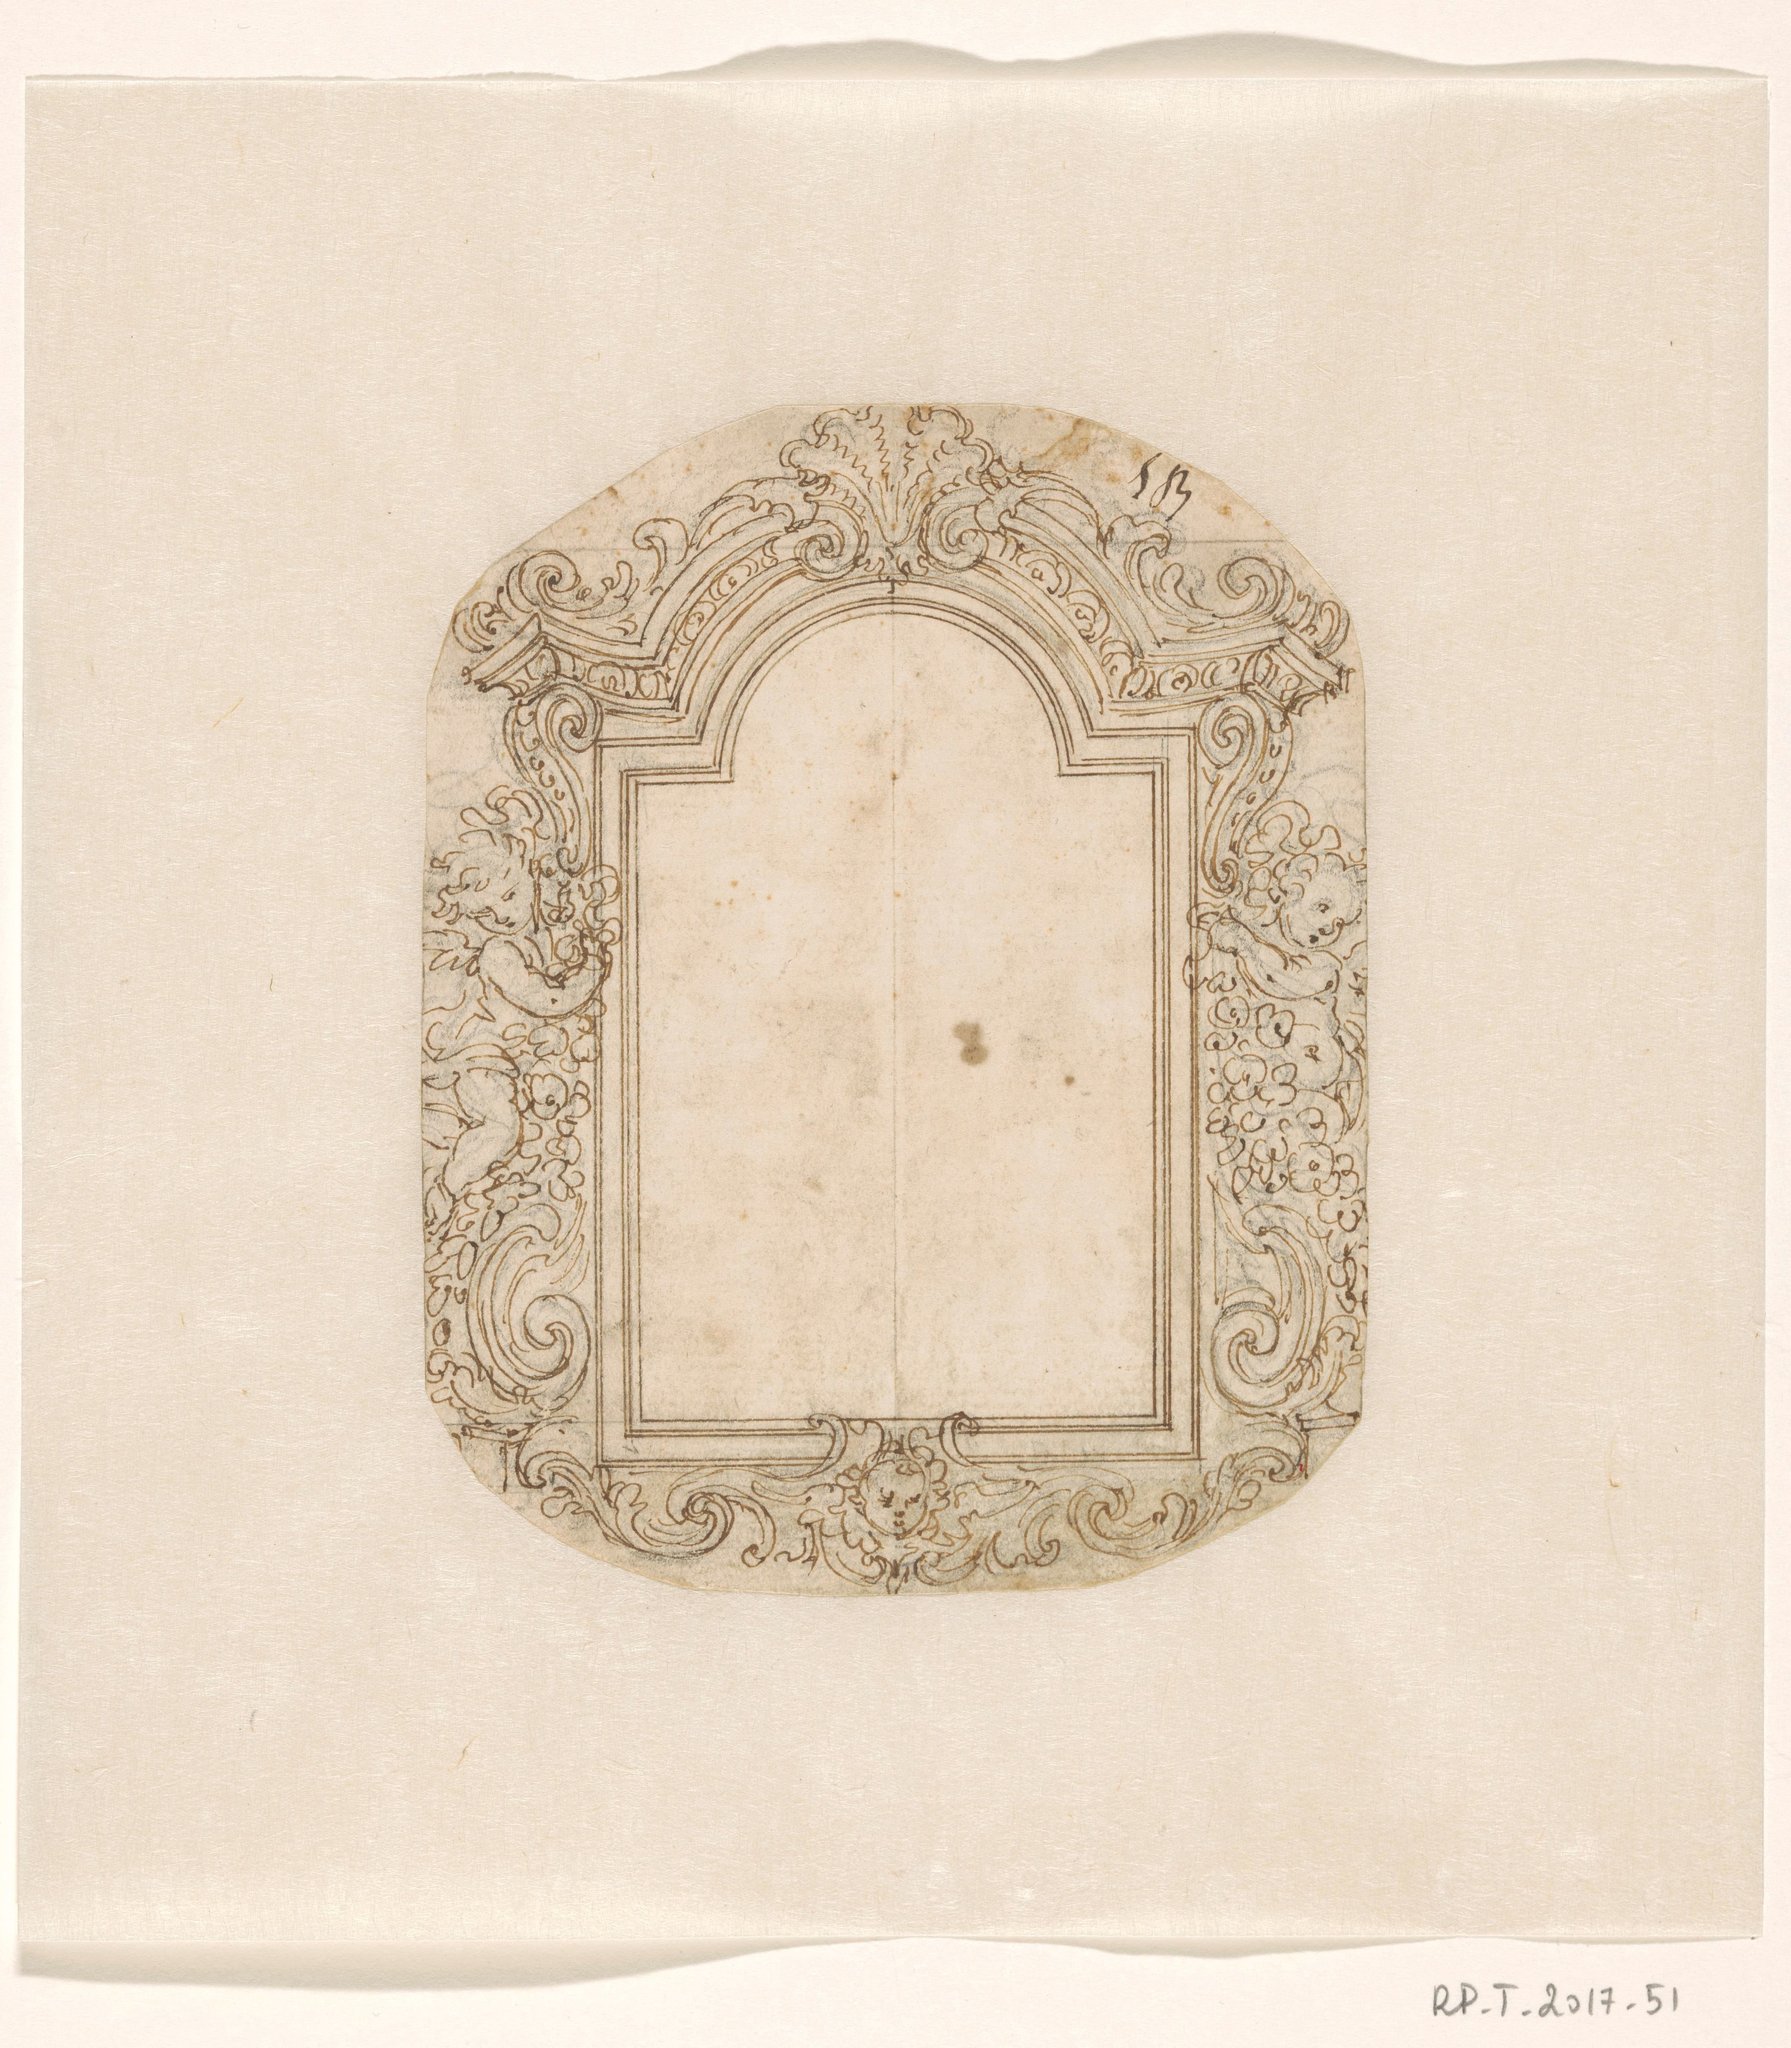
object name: drawing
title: Ontwerp voor een lijst met twee putti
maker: giovanni battista foggini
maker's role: draughtsman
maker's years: 1652-1725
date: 1700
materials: graphite, ink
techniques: drawing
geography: florence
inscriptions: inscription: ‘SB’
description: De tekening is uit een groter blad geknipt, waarbij het ontwerp is aangesneden, en op vrij dik papier geplakt. De achterzijde is leeg.